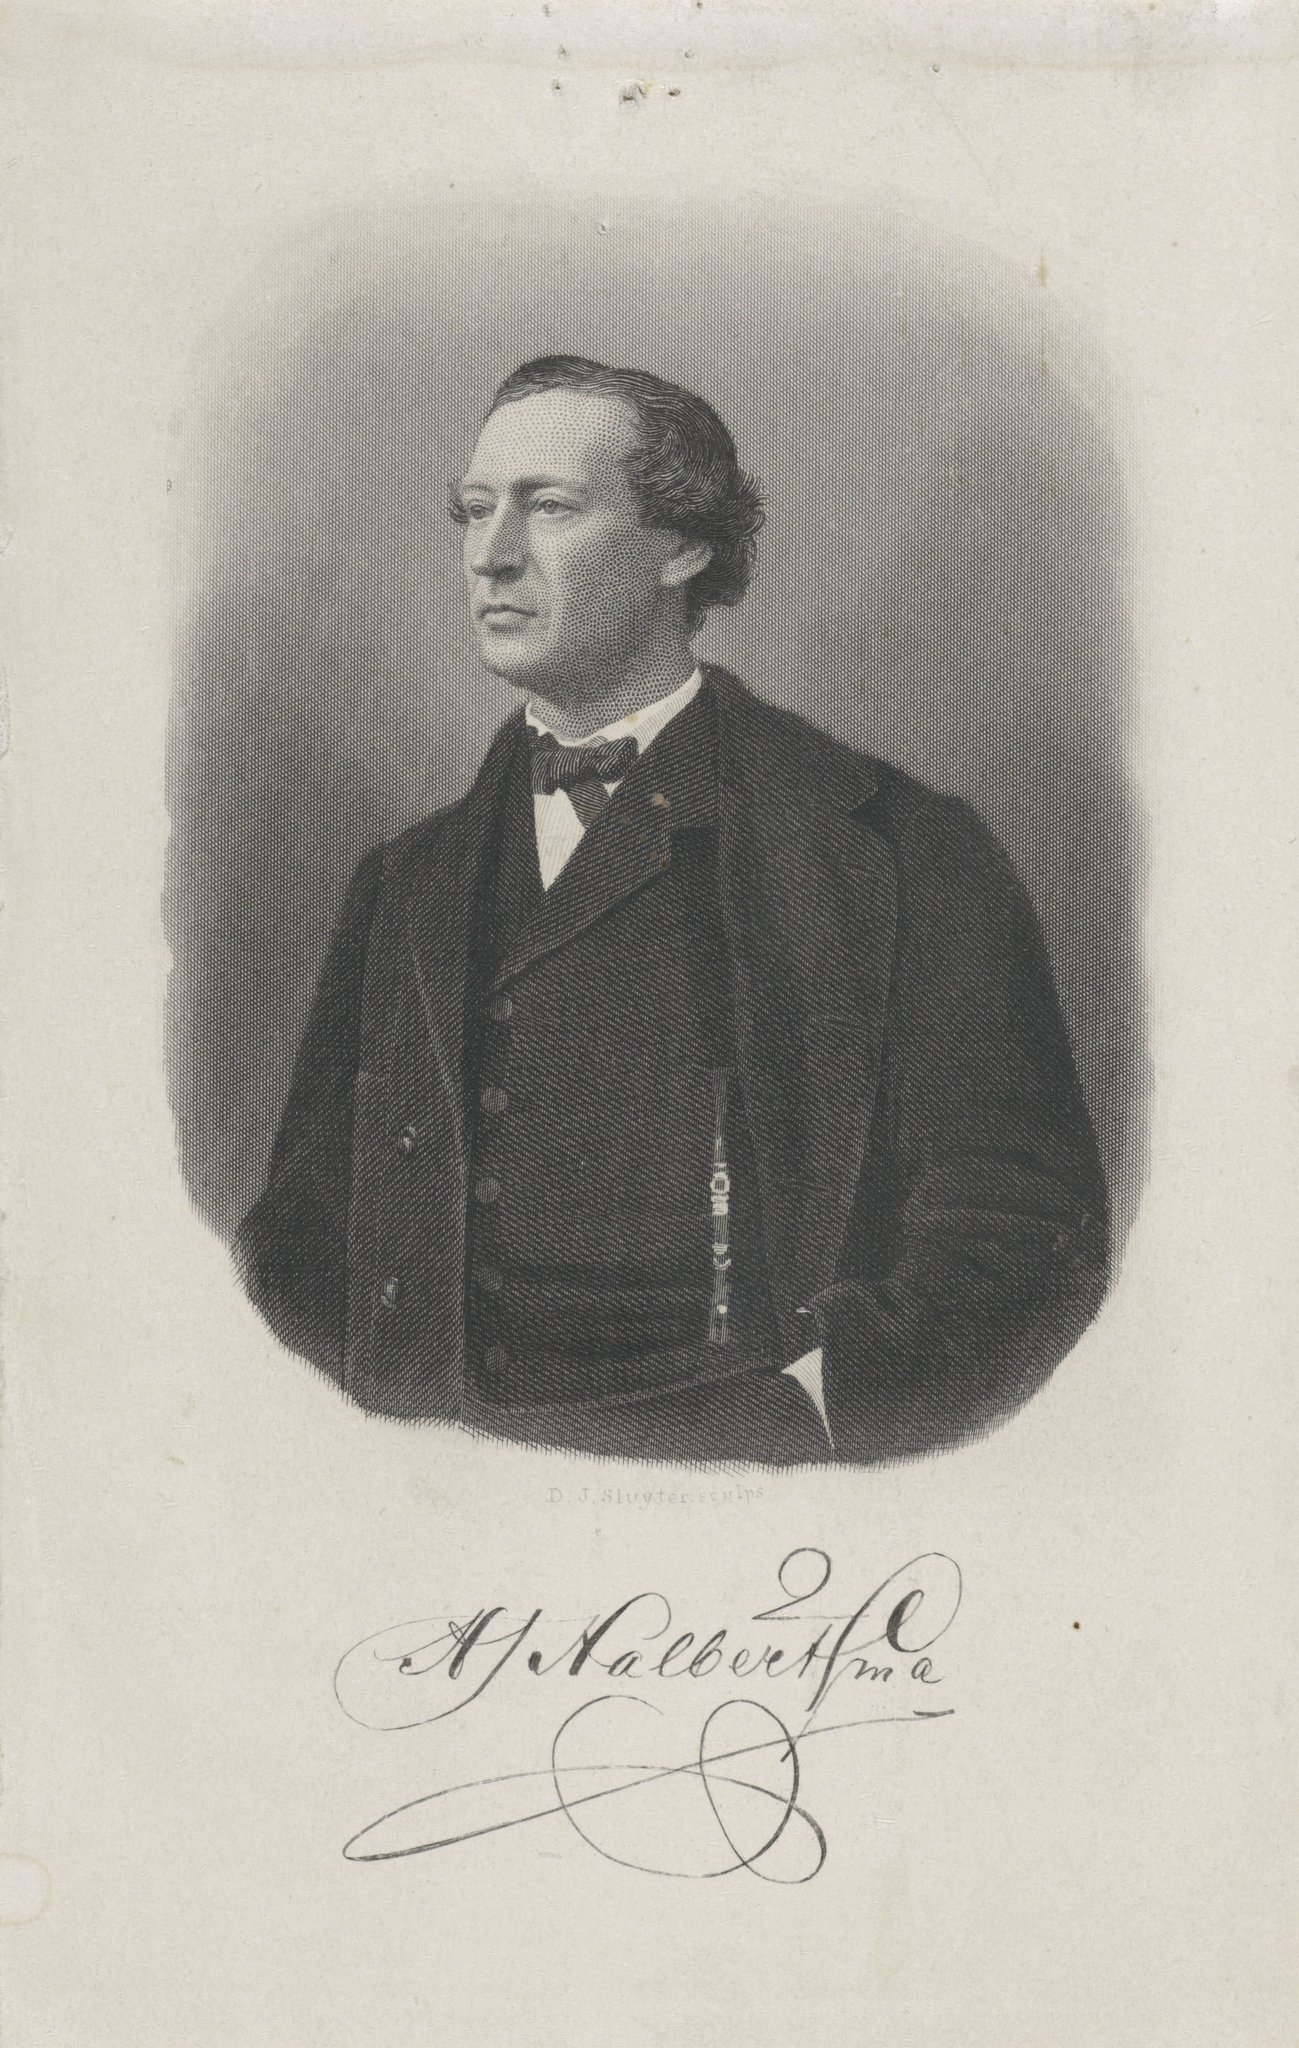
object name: print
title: Portret van de arts en hoogleraar Hidde Justusz. Halbertsma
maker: dirk jurriaan sluyter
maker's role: draughtsman, print maker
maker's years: 1811-1886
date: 1840-1886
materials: paper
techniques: etching, engraving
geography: amsterdam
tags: bolsward, koblenz, arts, hidde justusz. halbertsma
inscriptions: collector's mark: Lugt 2228